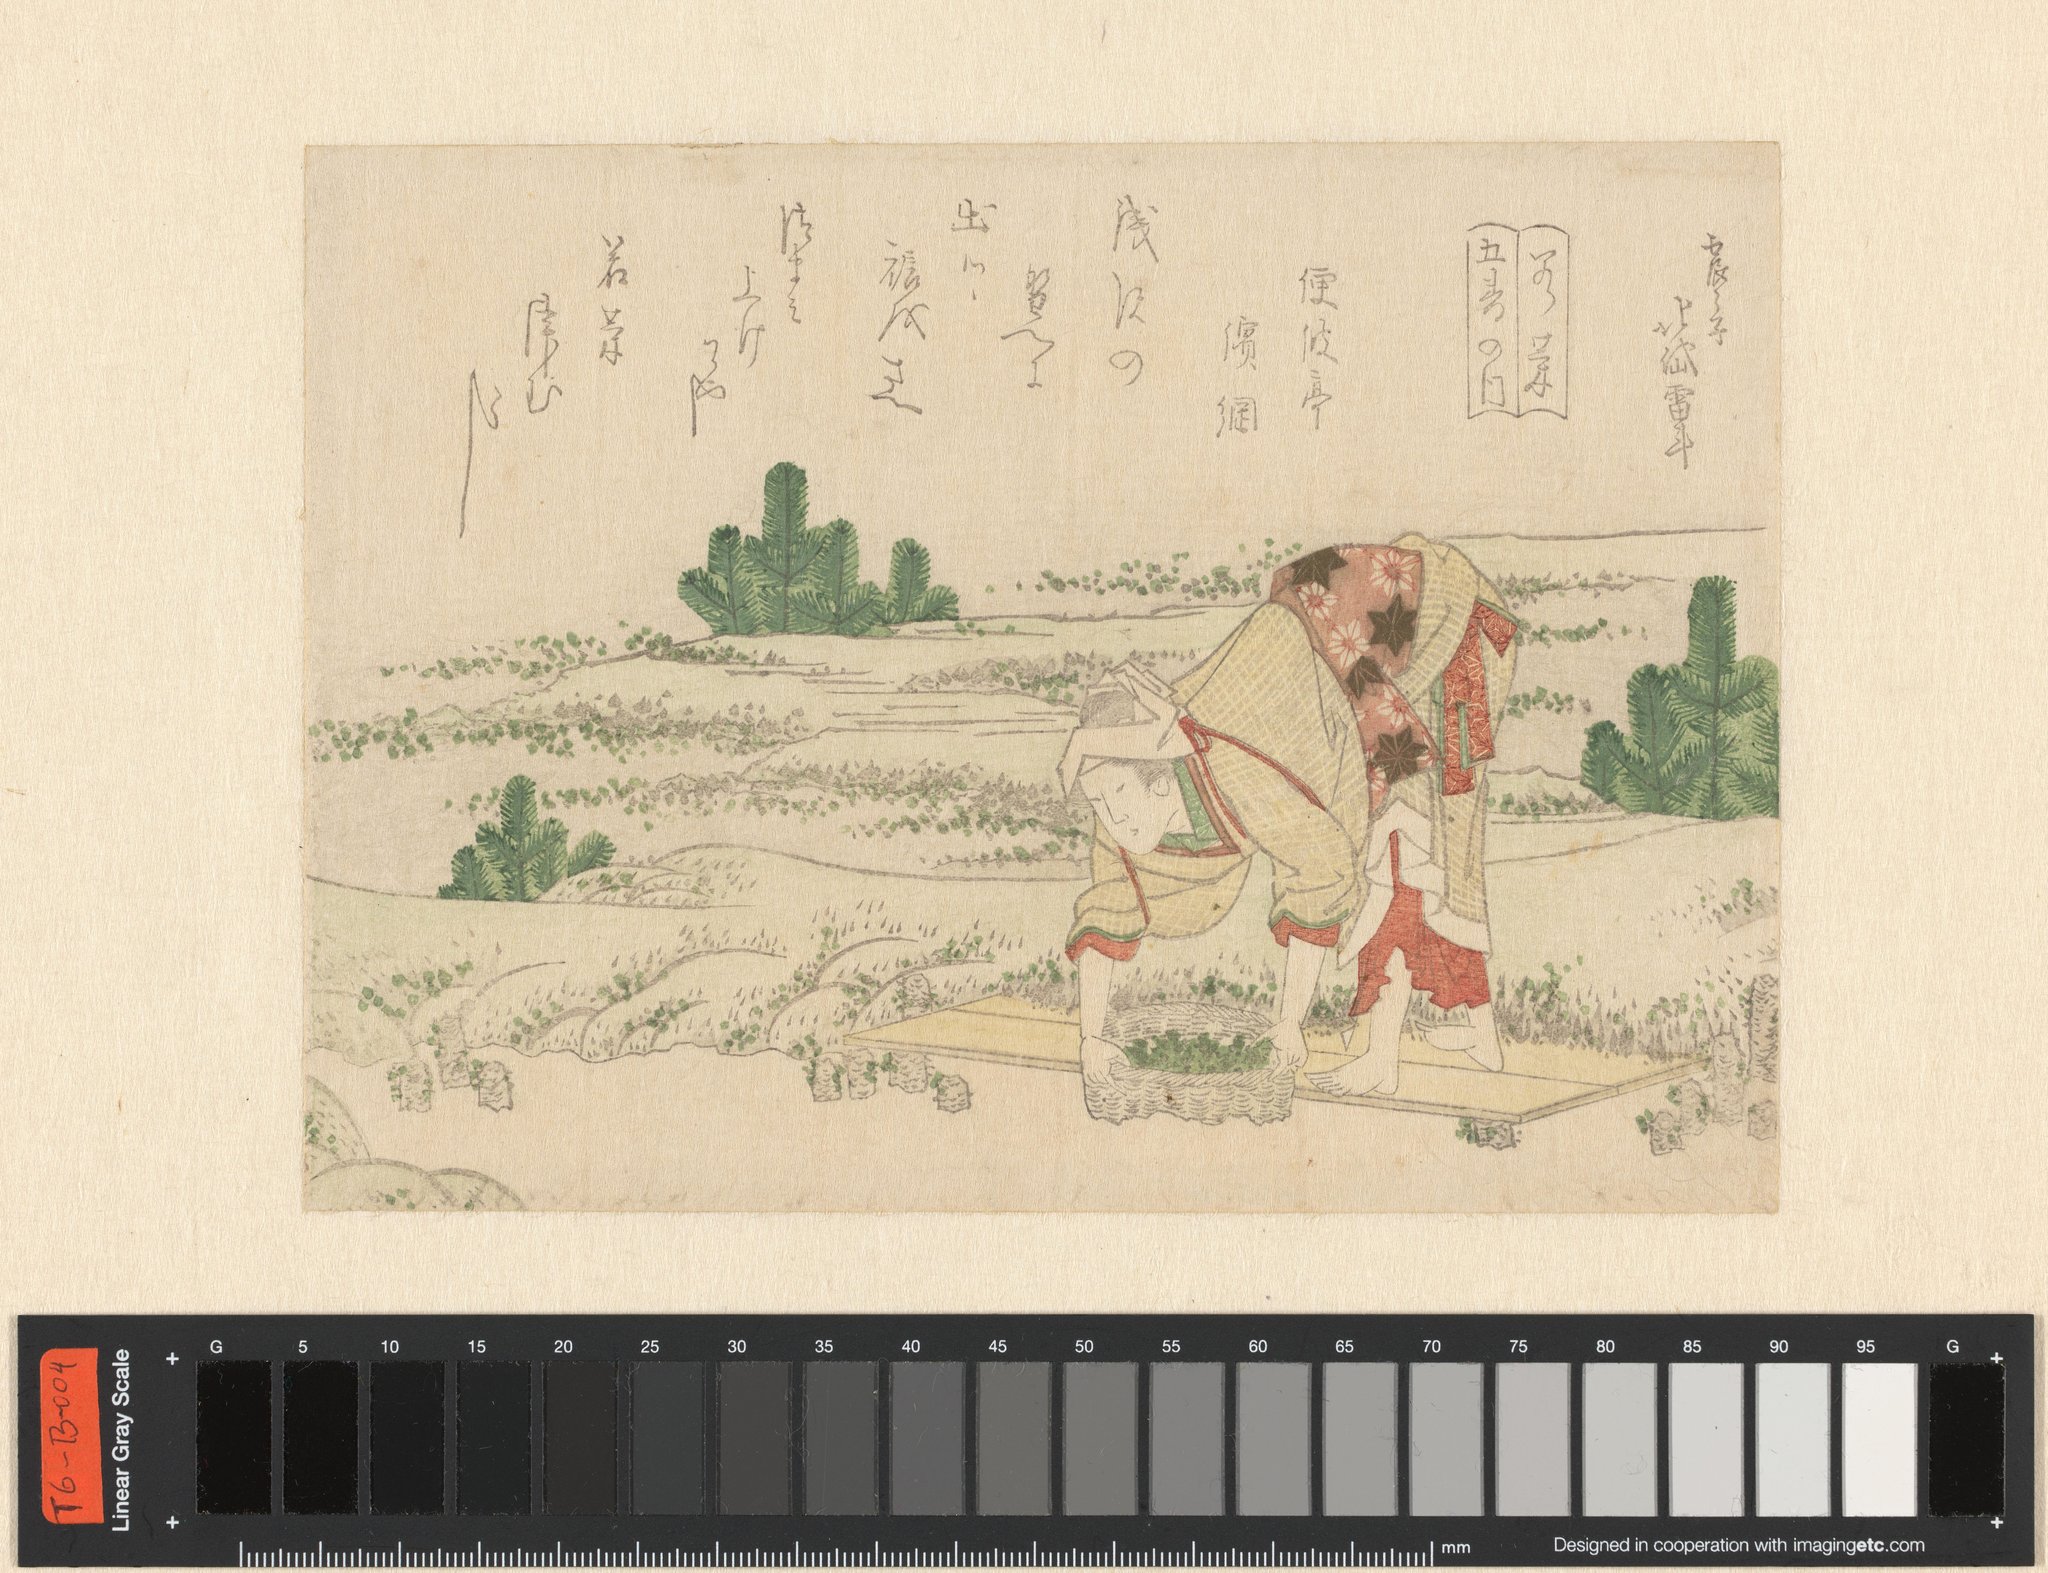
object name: surimono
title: Kruiden plukken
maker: katsushika hokutai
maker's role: print maker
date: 1820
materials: paper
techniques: woodcut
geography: japan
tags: bending figure, gathering herbs, landscapes (+ landscape with figures, staffage)